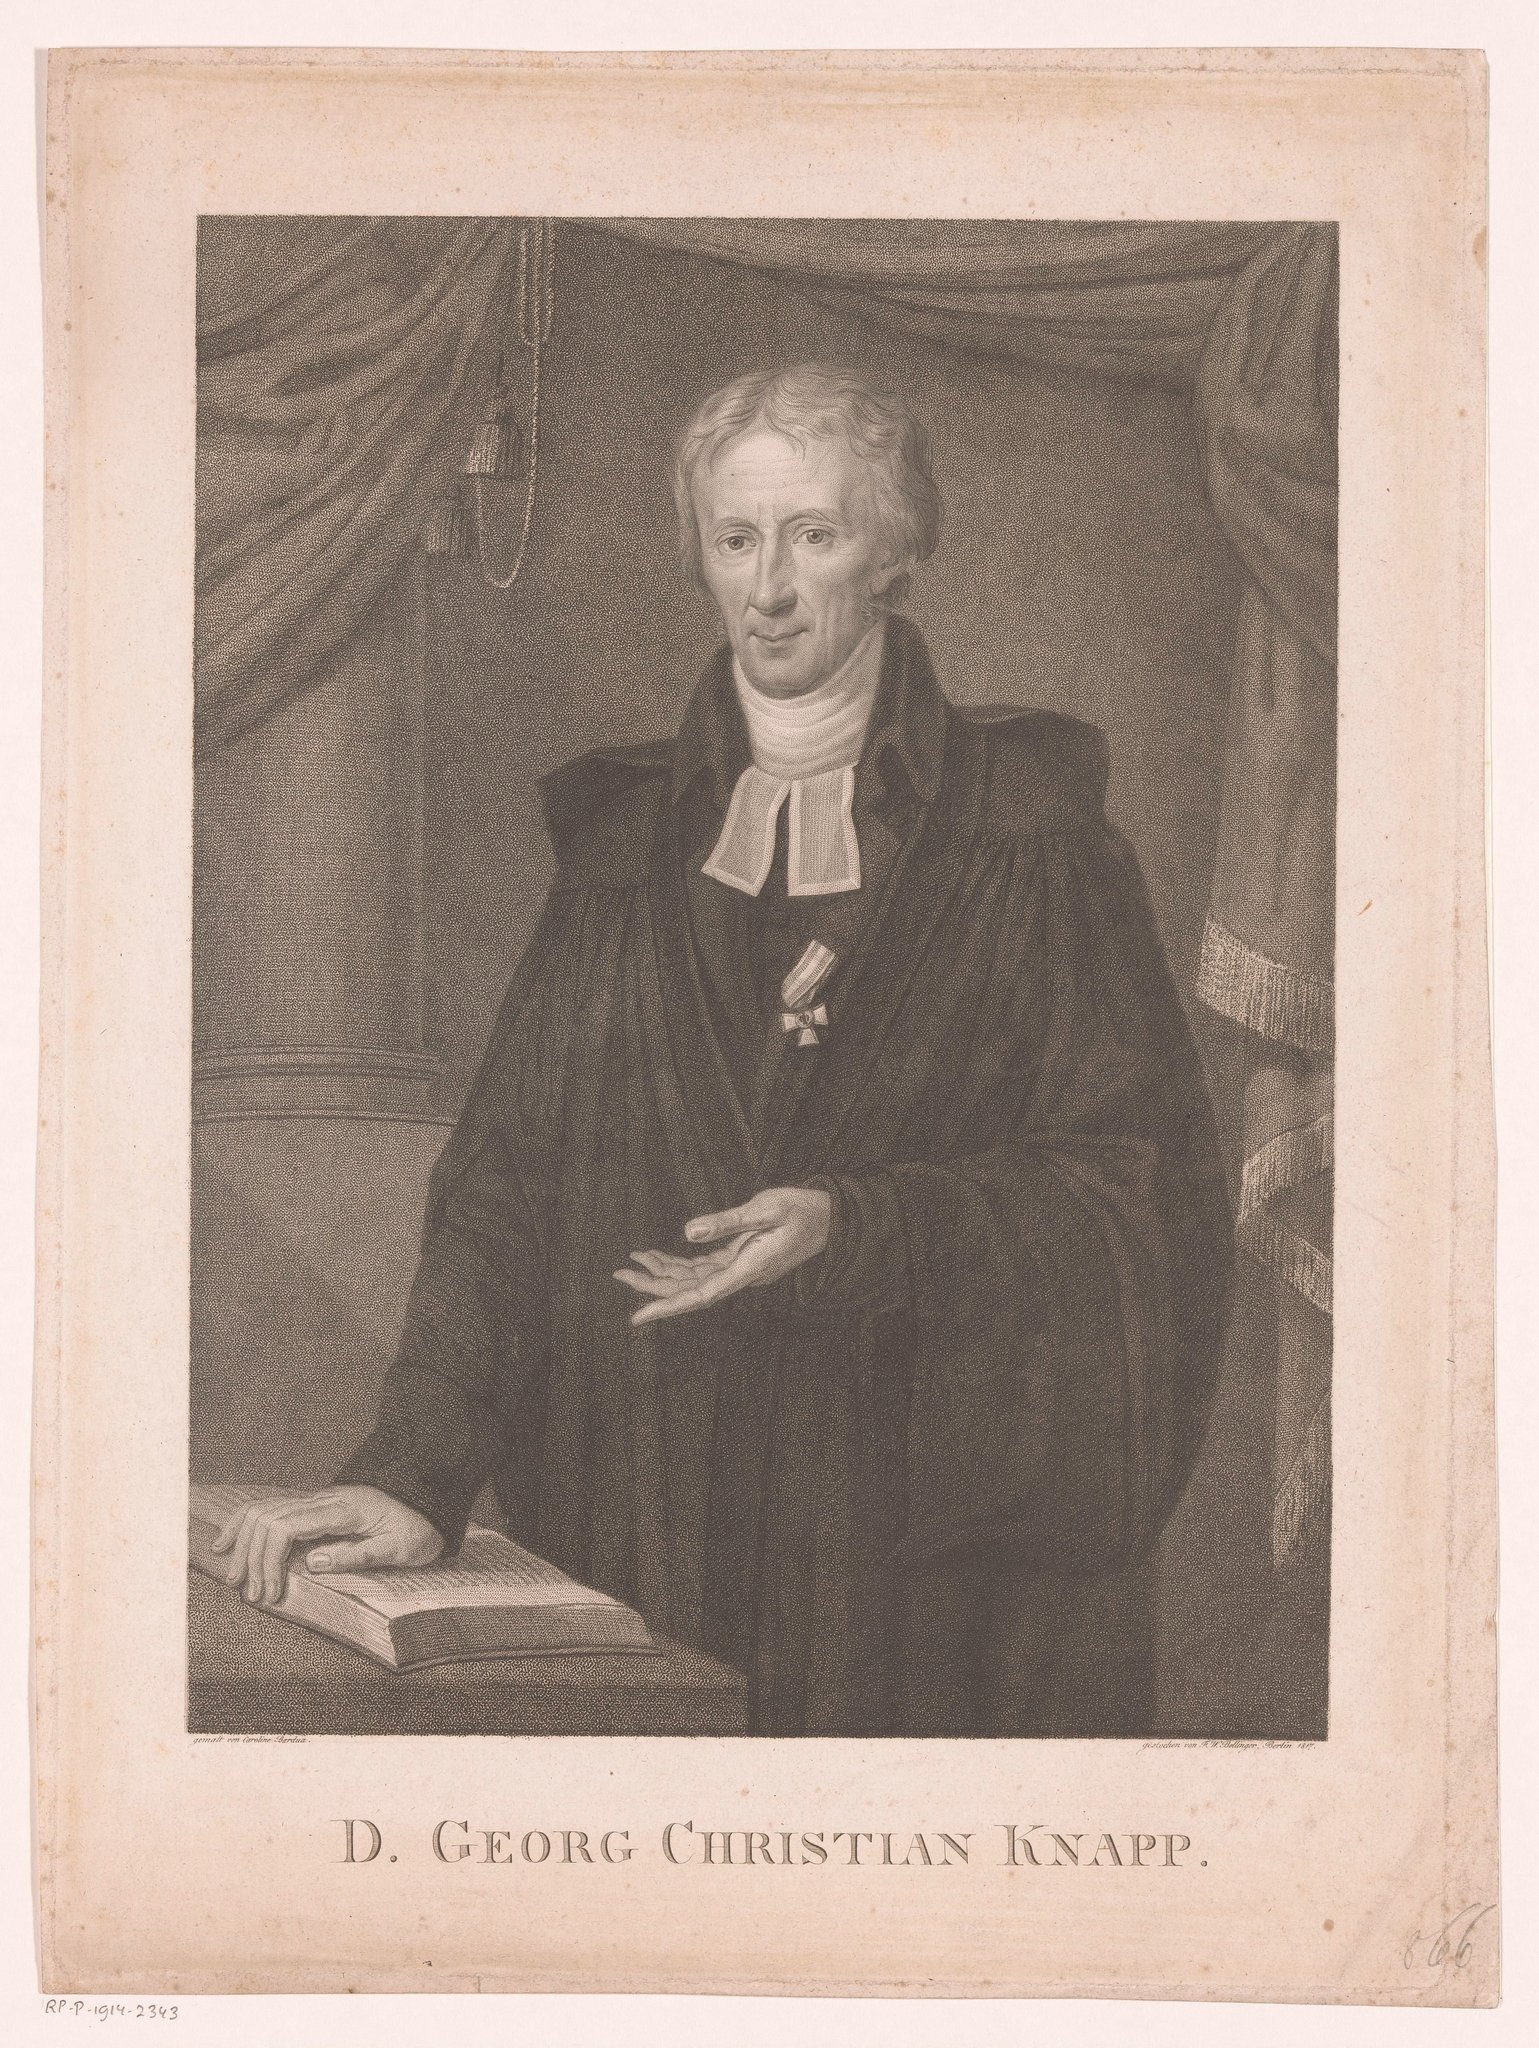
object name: print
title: Georg Christi Knapp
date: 1817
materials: paper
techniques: stippling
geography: berlin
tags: knighthood order, historical persons, book - mm - book open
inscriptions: collector's mark: Lugt 2228